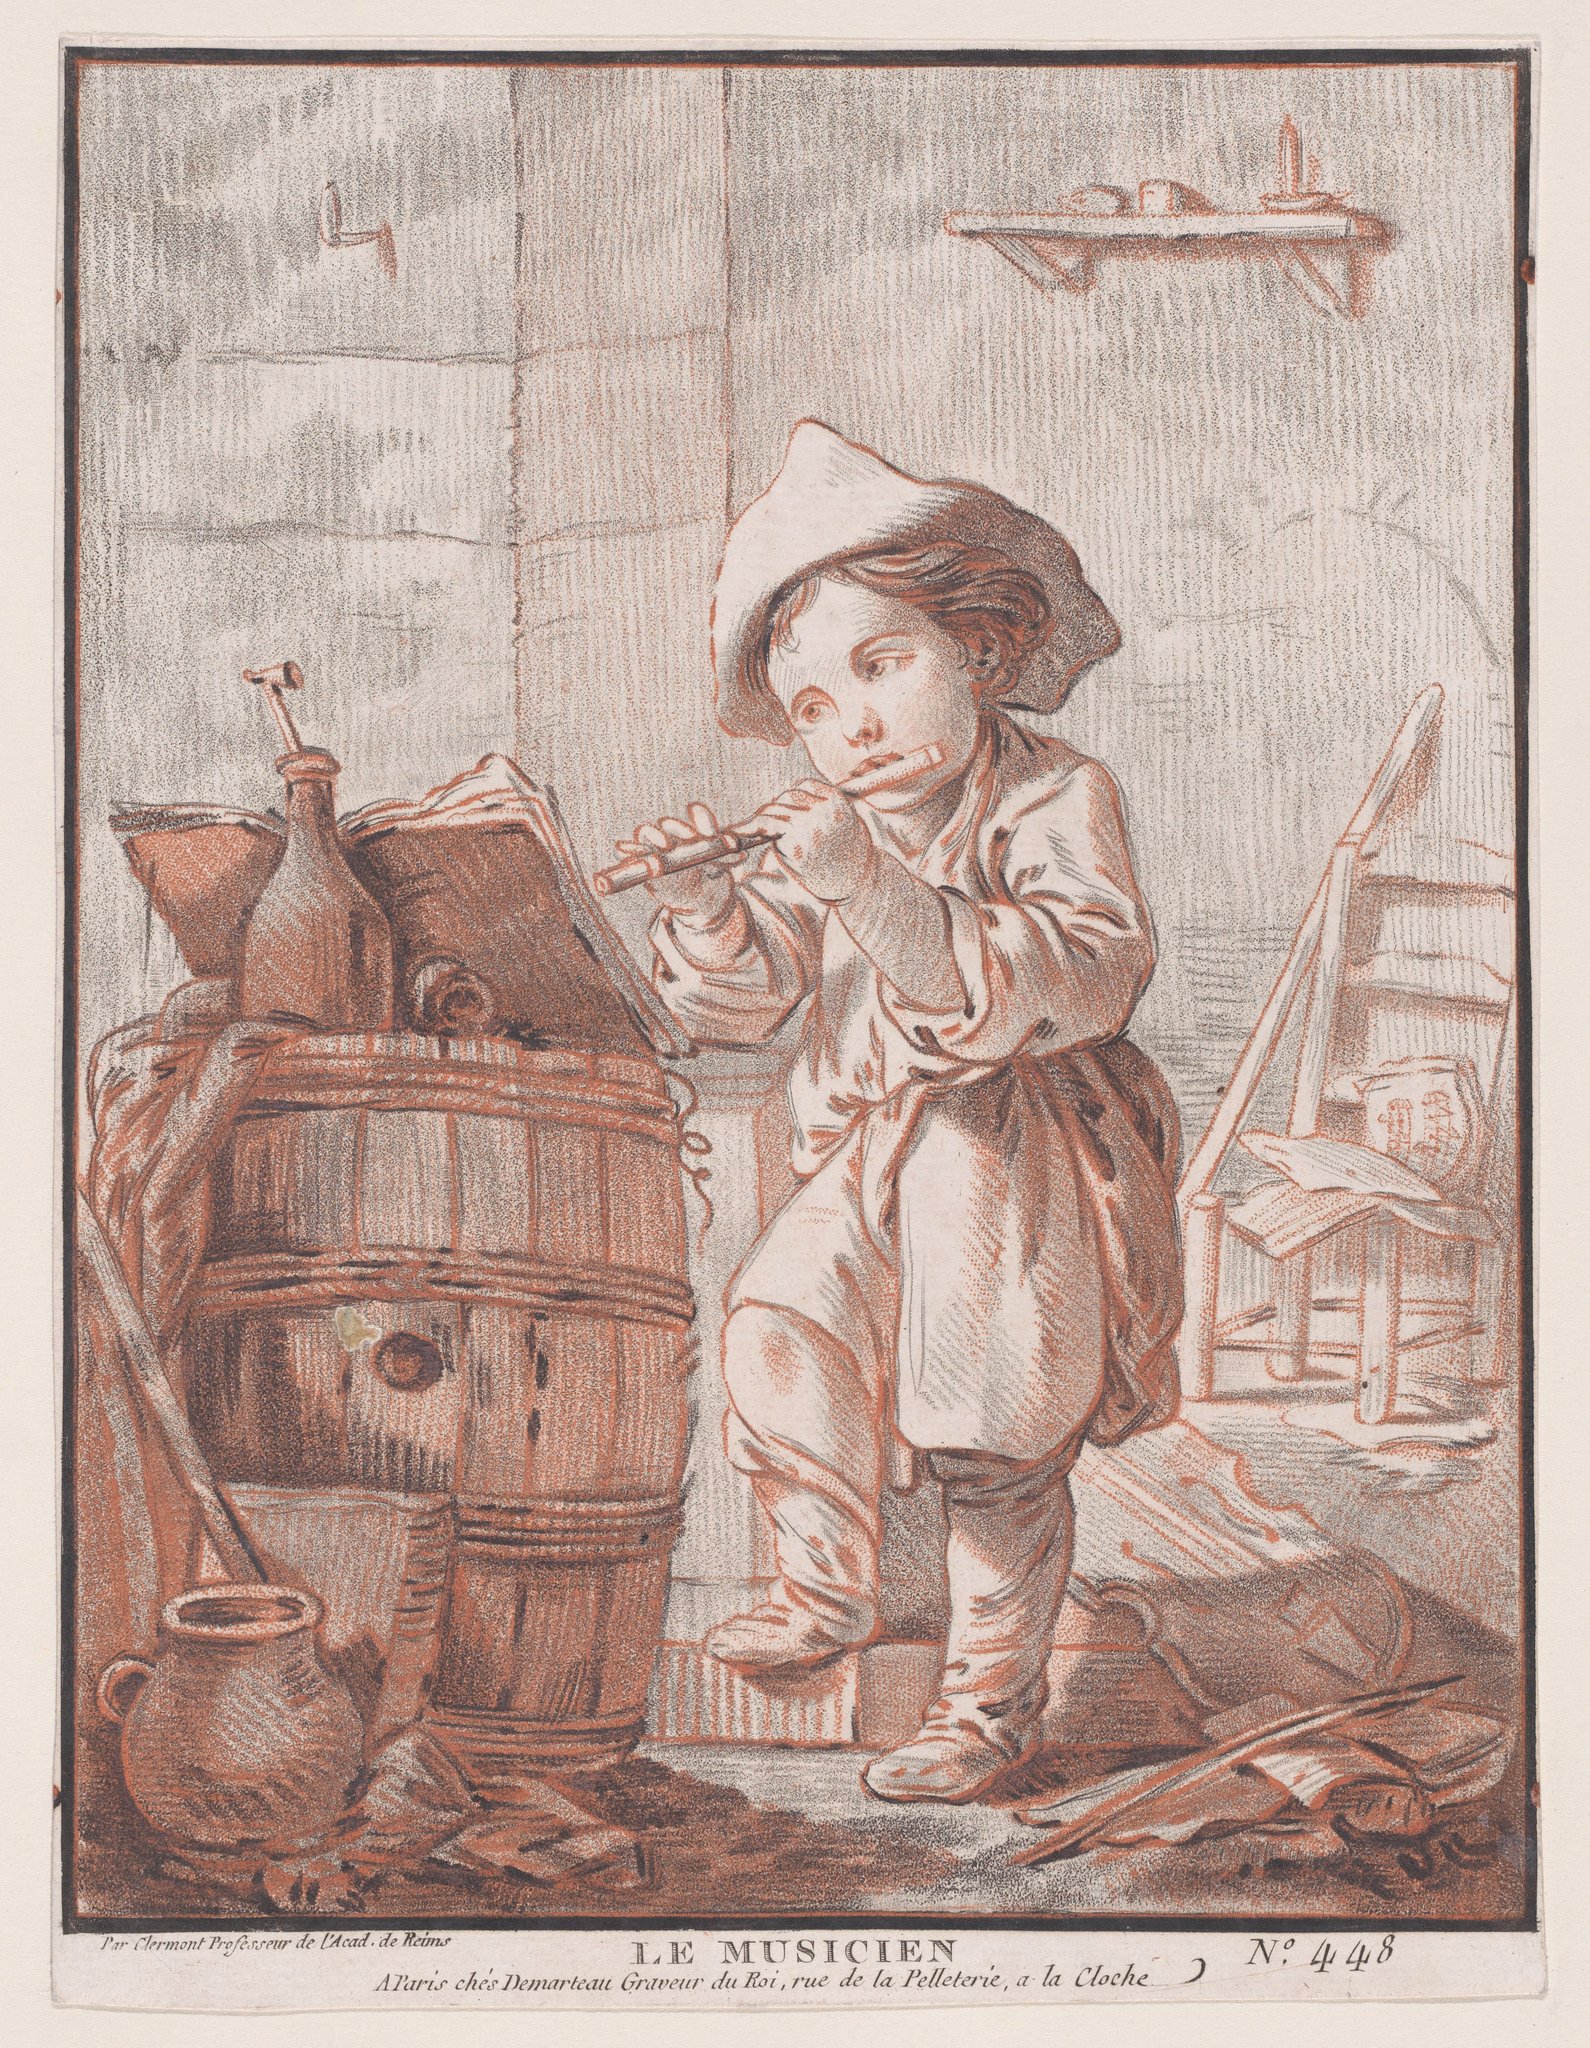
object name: print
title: Le Musicien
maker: gilles demarteau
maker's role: artist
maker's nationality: french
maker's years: 1722-1776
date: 1701-1800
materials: ink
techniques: printmaking, etching, printing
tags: boys,flutes,musicians